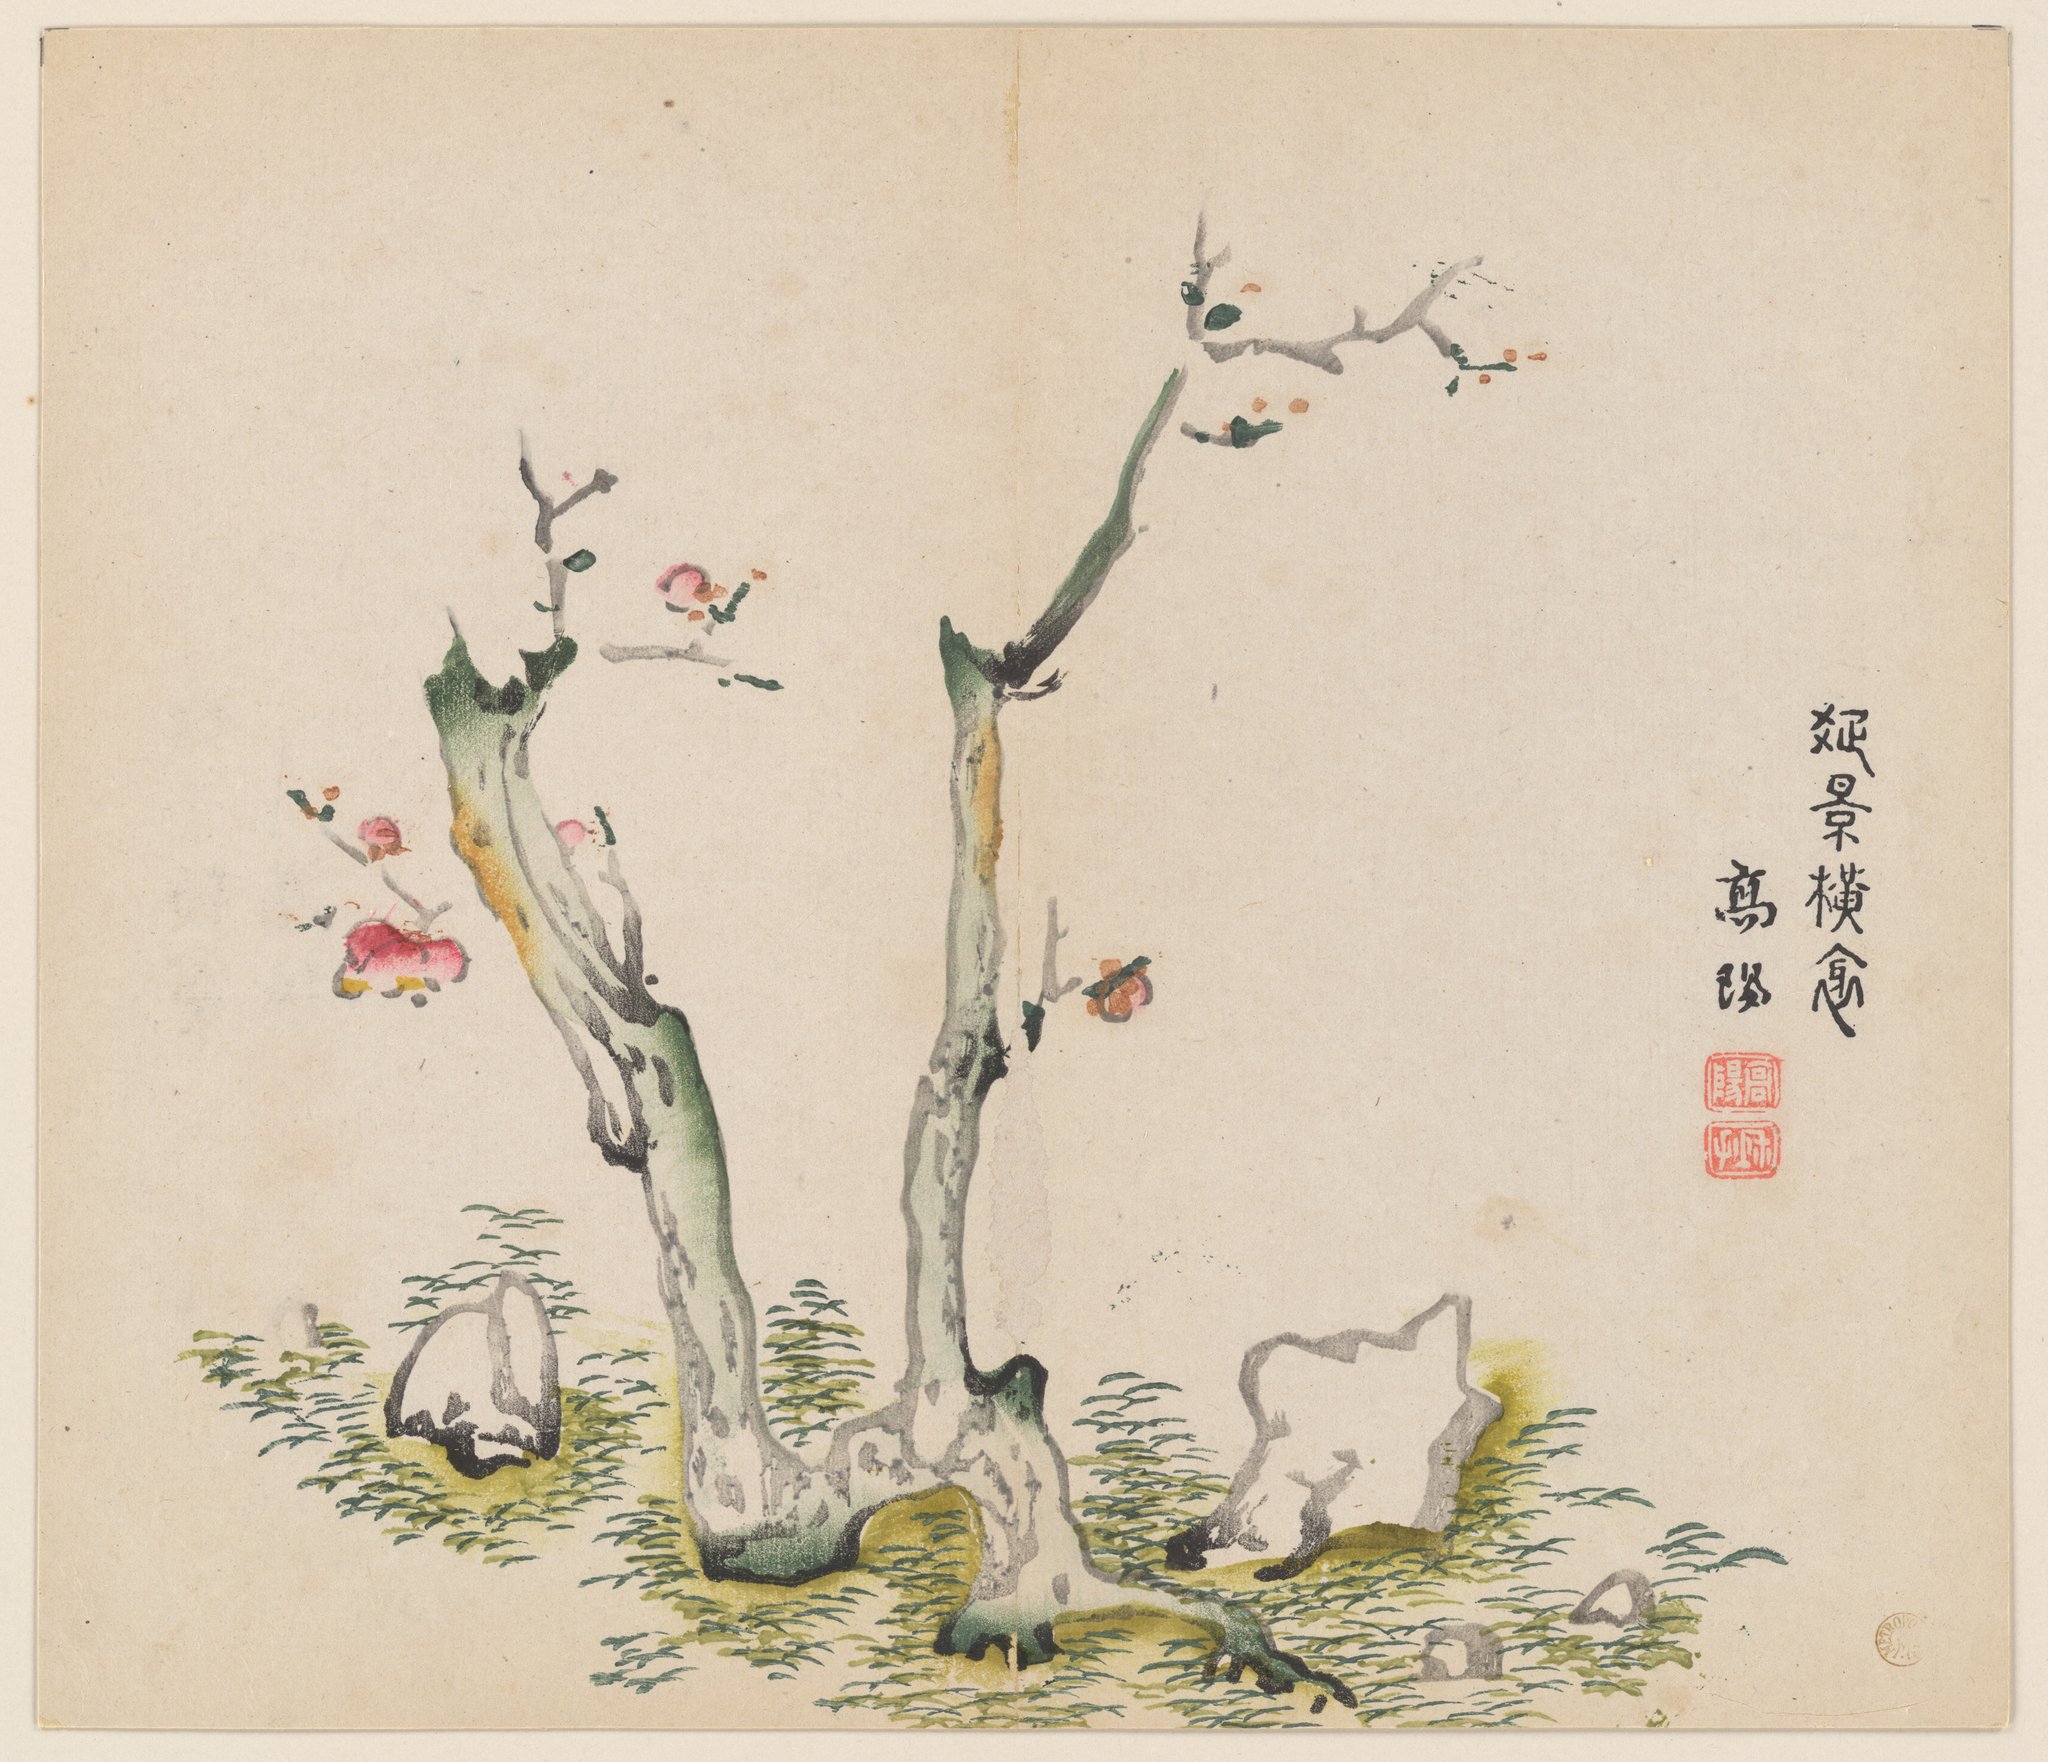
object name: print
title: Page from the Ten Bamboo Studio Manual of Painting and Calligraphy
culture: chinese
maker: hu zhengyan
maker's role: artist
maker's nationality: chinese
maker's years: 1584-1634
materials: ink, paper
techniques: printing